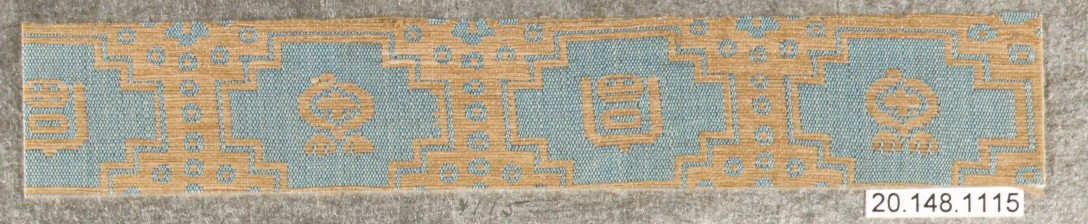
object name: piece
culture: japanese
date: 1701-1800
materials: silk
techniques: compound weave